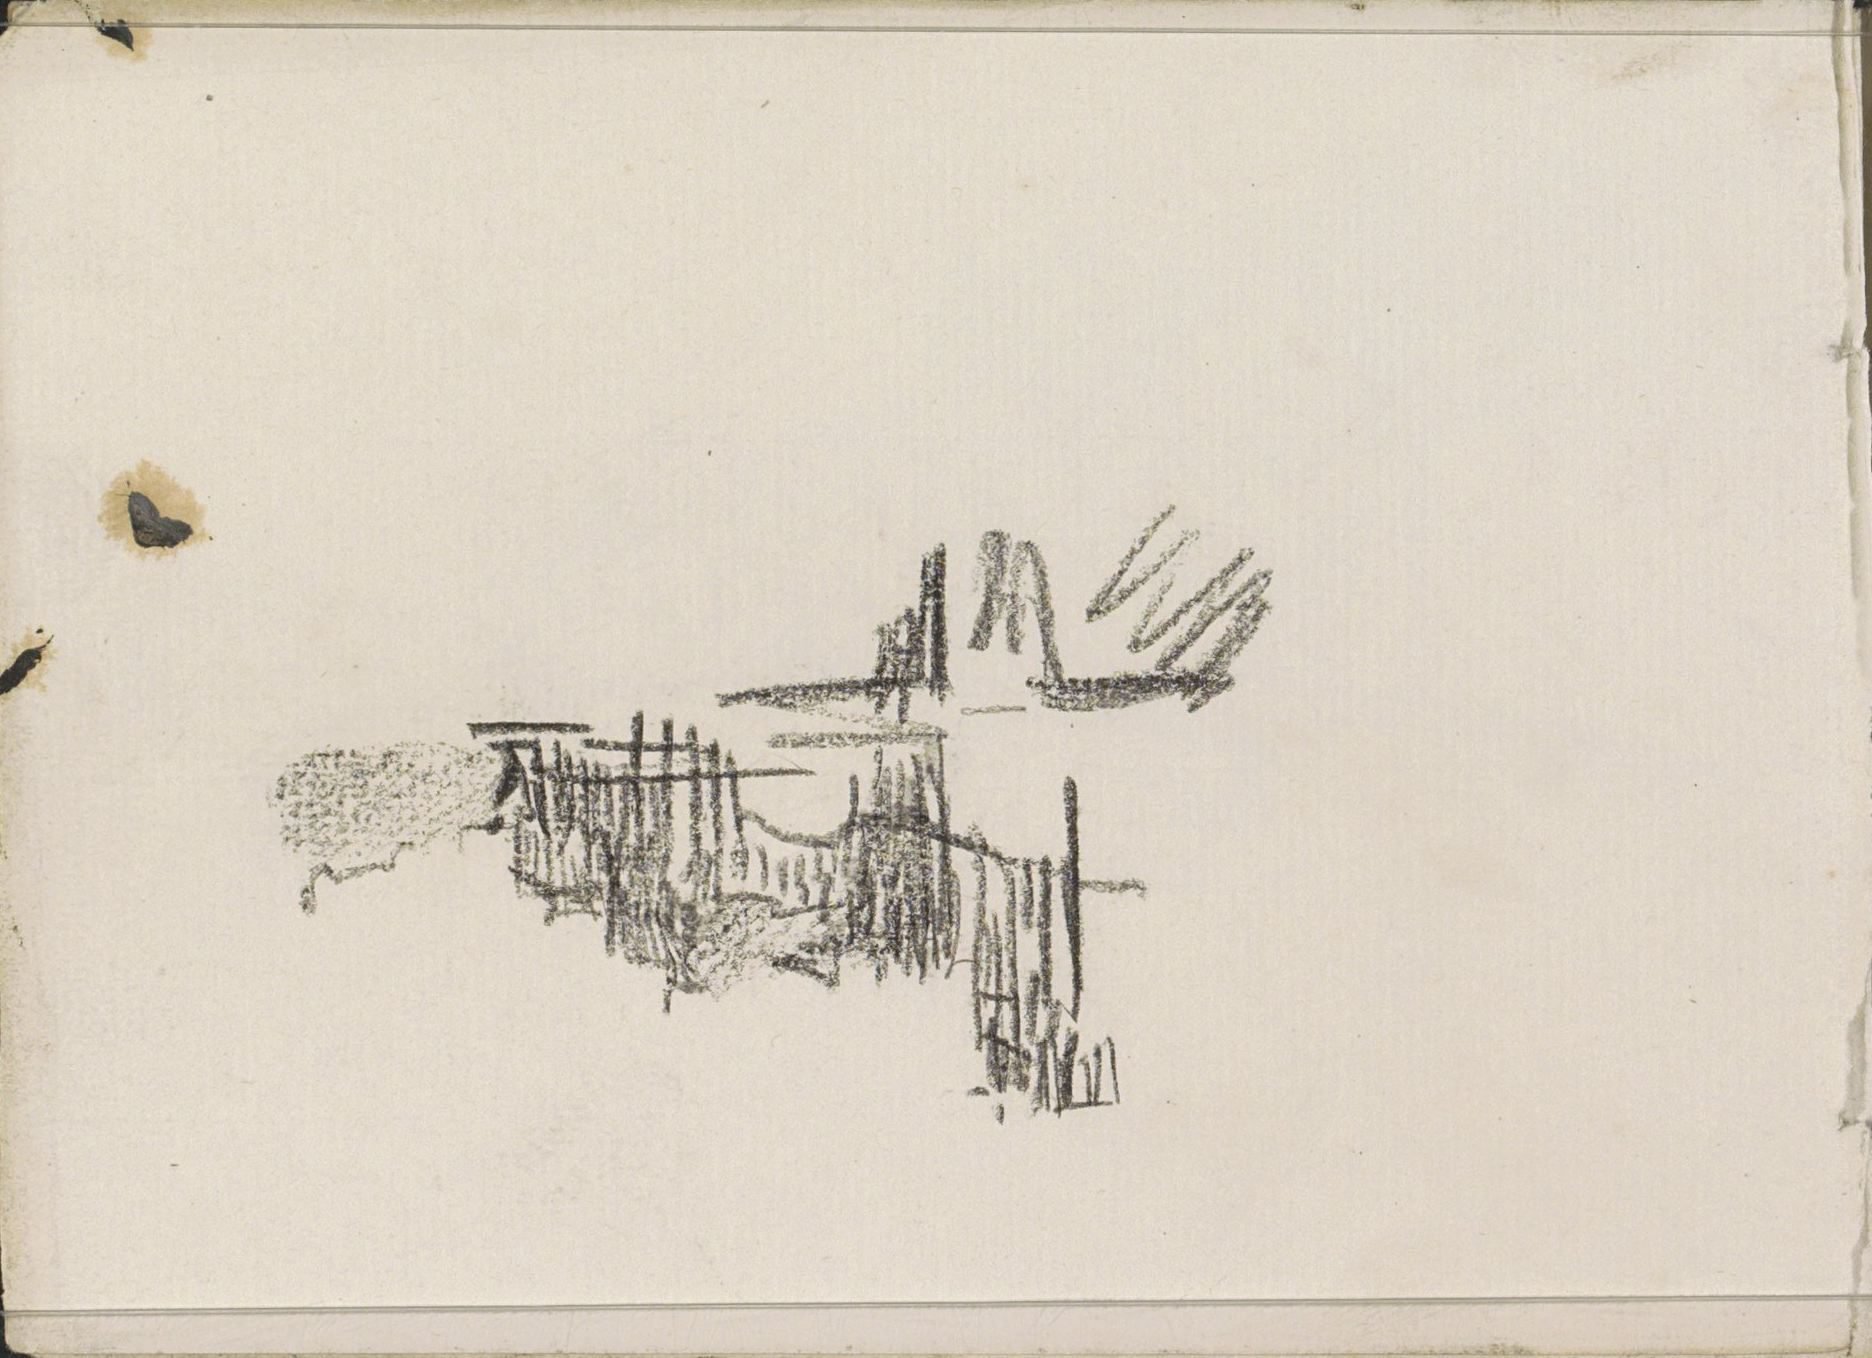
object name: sketchbook leaf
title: Stadsgezicht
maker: isaac israels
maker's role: draughtsman, painter, print maker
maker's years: 1865-1934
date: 1886-1903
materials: chalk, paper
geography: amsterdam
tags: bridge in city across river, canal, etc., amsterdam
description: Mogelijk Amsterdam. Pagina 4 uit schetsboek XLVII met 52 pagina's.